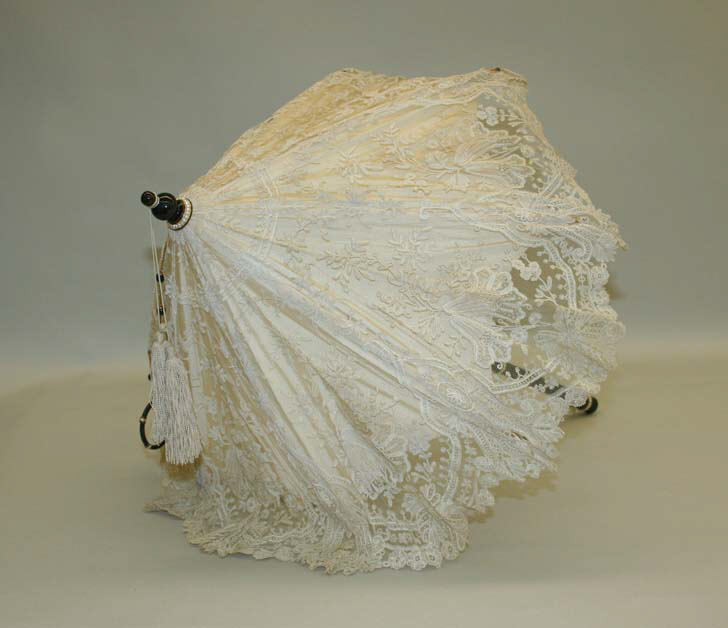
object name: parasol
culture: french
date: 1845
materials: cotton, ivory, metal, pearl, silk, stone